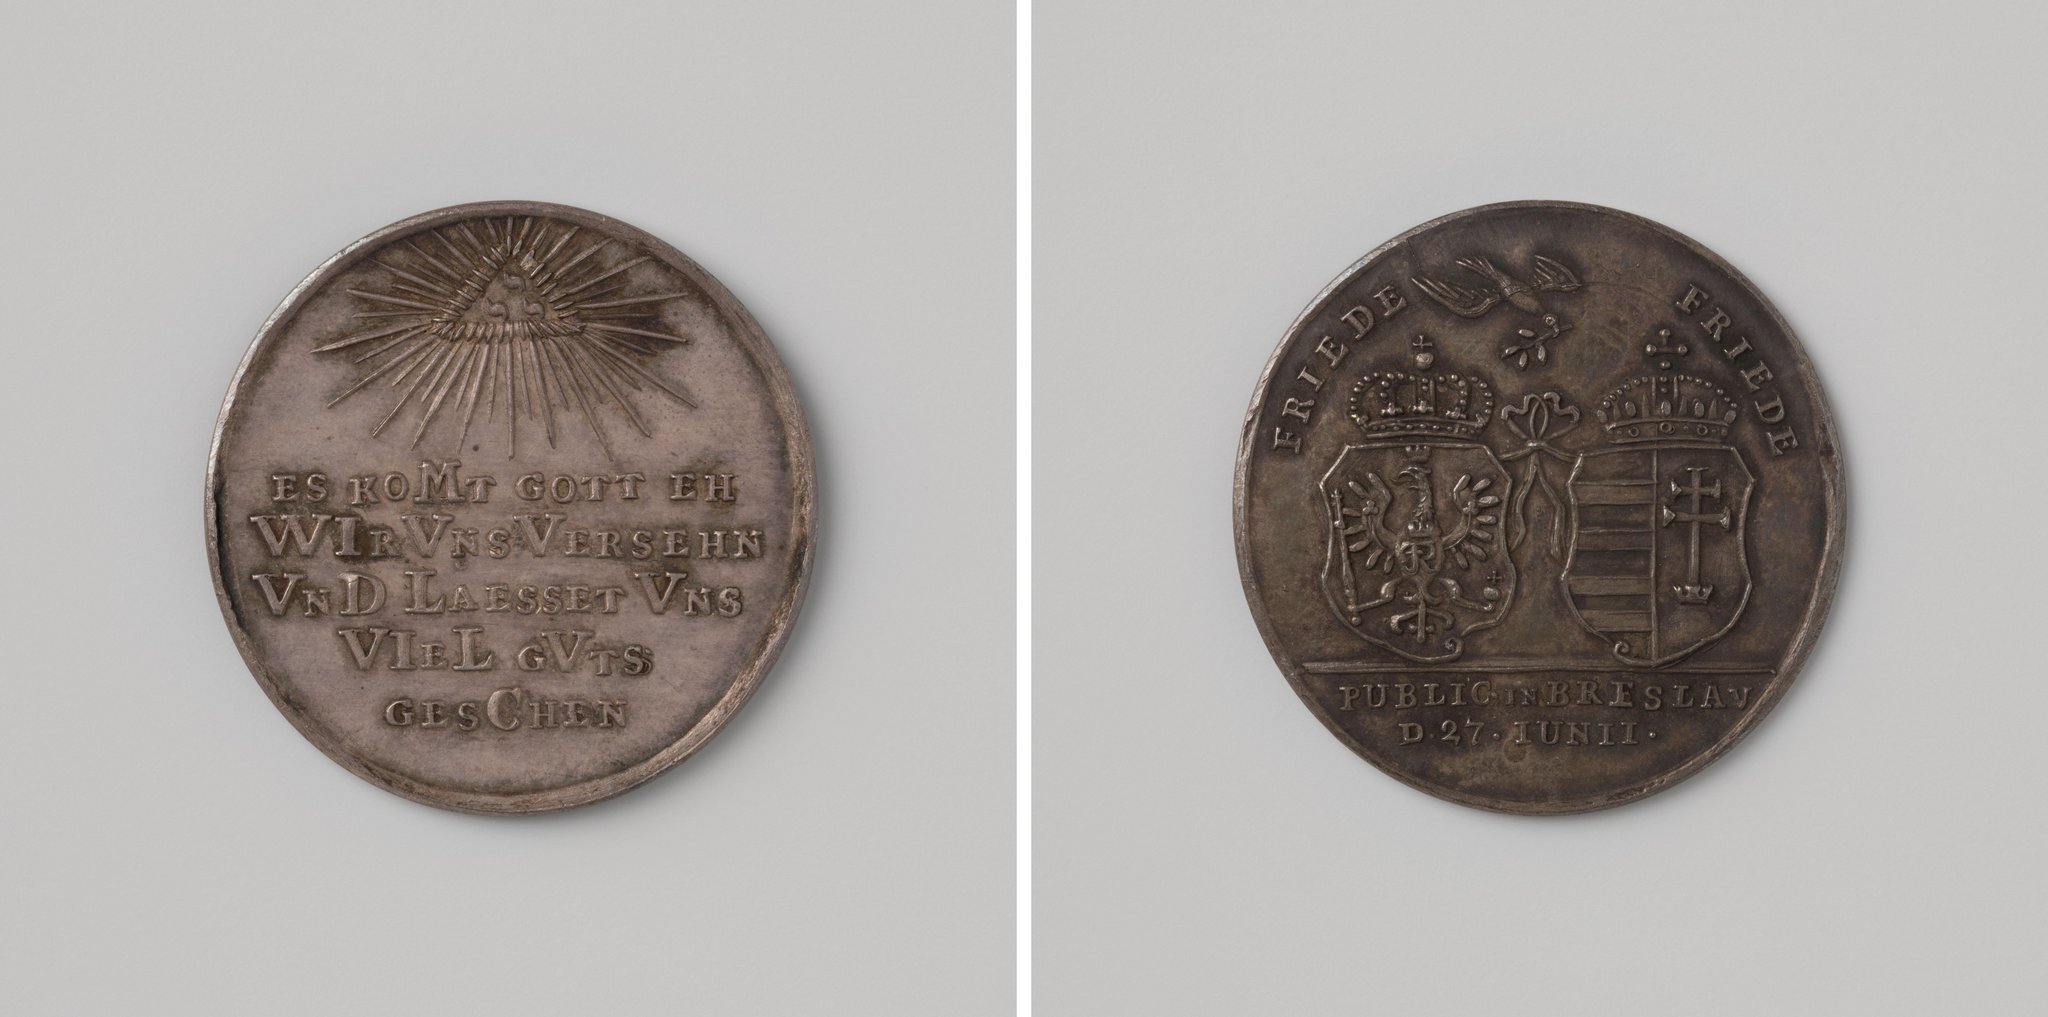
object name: history medal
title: Voorlopige vrede van Breslau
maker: Anonymous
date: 1742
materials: silver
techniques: striking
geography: germany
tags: wroclaw, voorlopige vrede van breslau